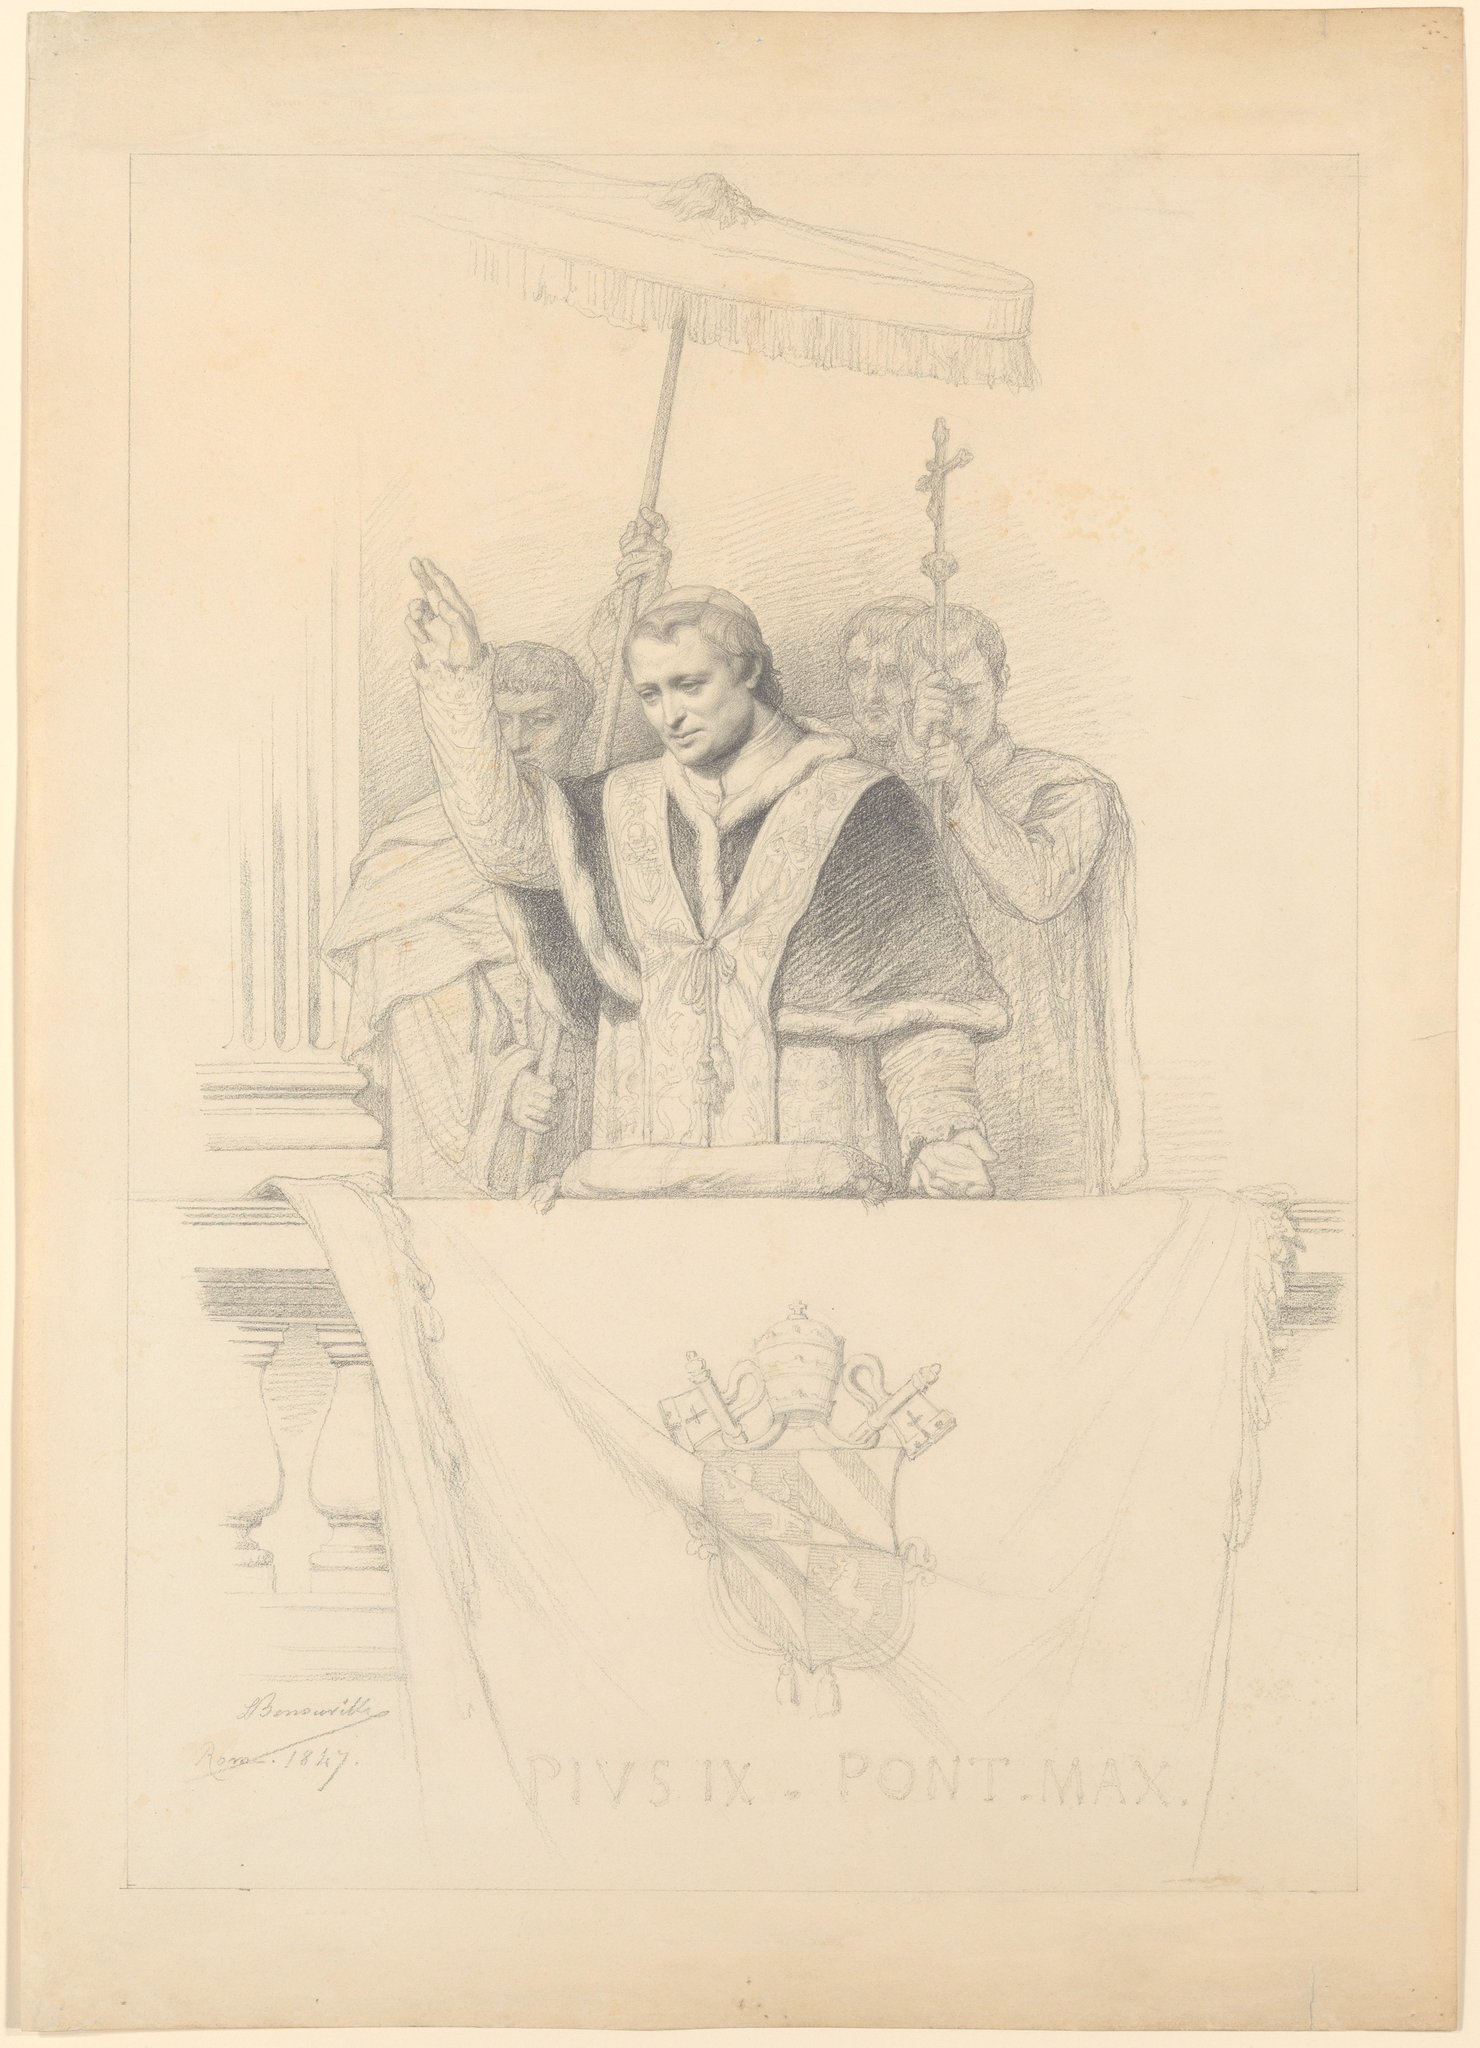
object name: drawing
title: Pope Pius IX Imparting the Blessing Urbi et Orbi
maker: françois-léon benouville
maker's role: artist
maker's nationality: french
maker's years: 1821-1859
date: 1847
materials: graphite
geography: france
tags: men,popes,insignia